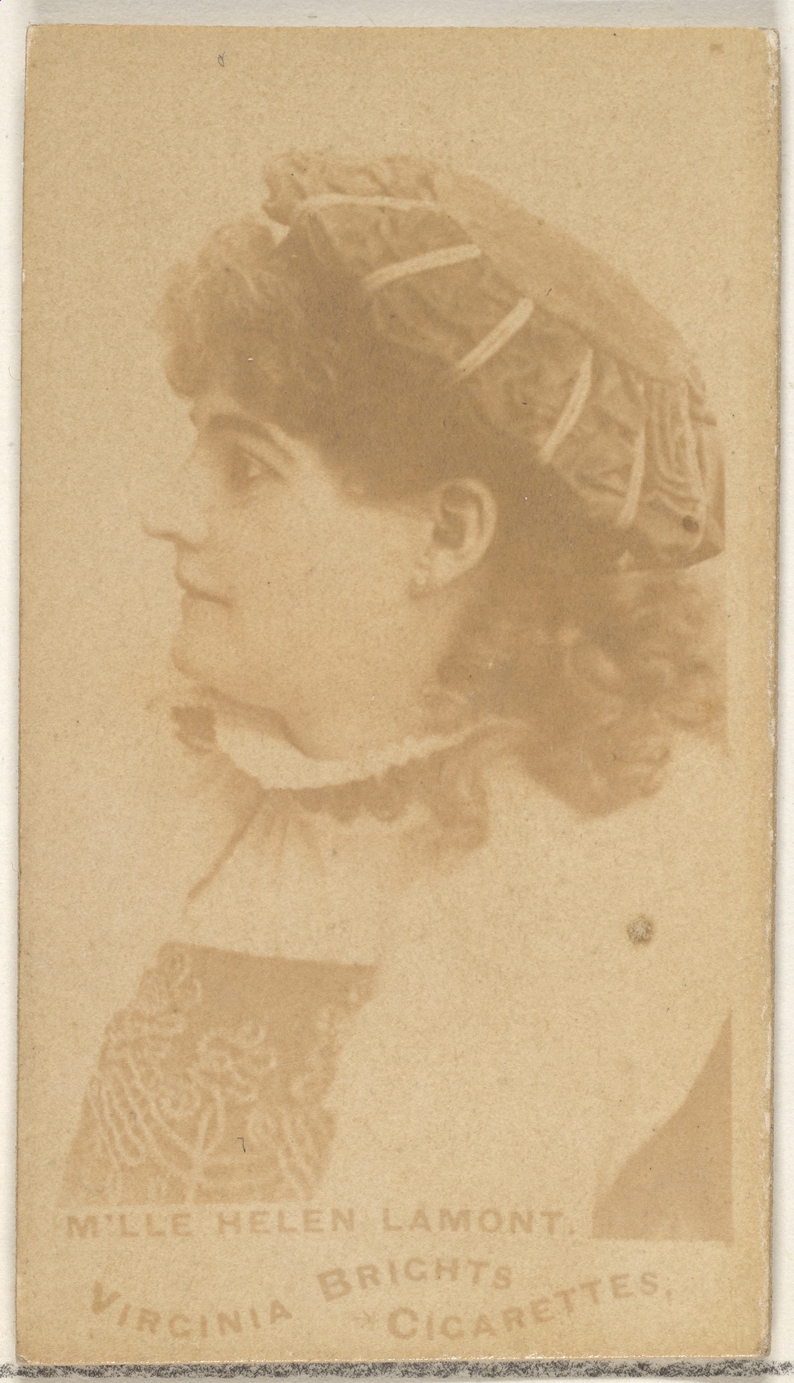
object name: photograph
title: Mlle. Helen Lamont, from the Actors and Actresses series (N45, Type 1) for Virginia Brights Cigarettes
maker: allen & ginter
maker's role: publisher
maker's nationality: american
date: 1888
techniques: albumen silver print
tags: portraits,profiles,women,actresses